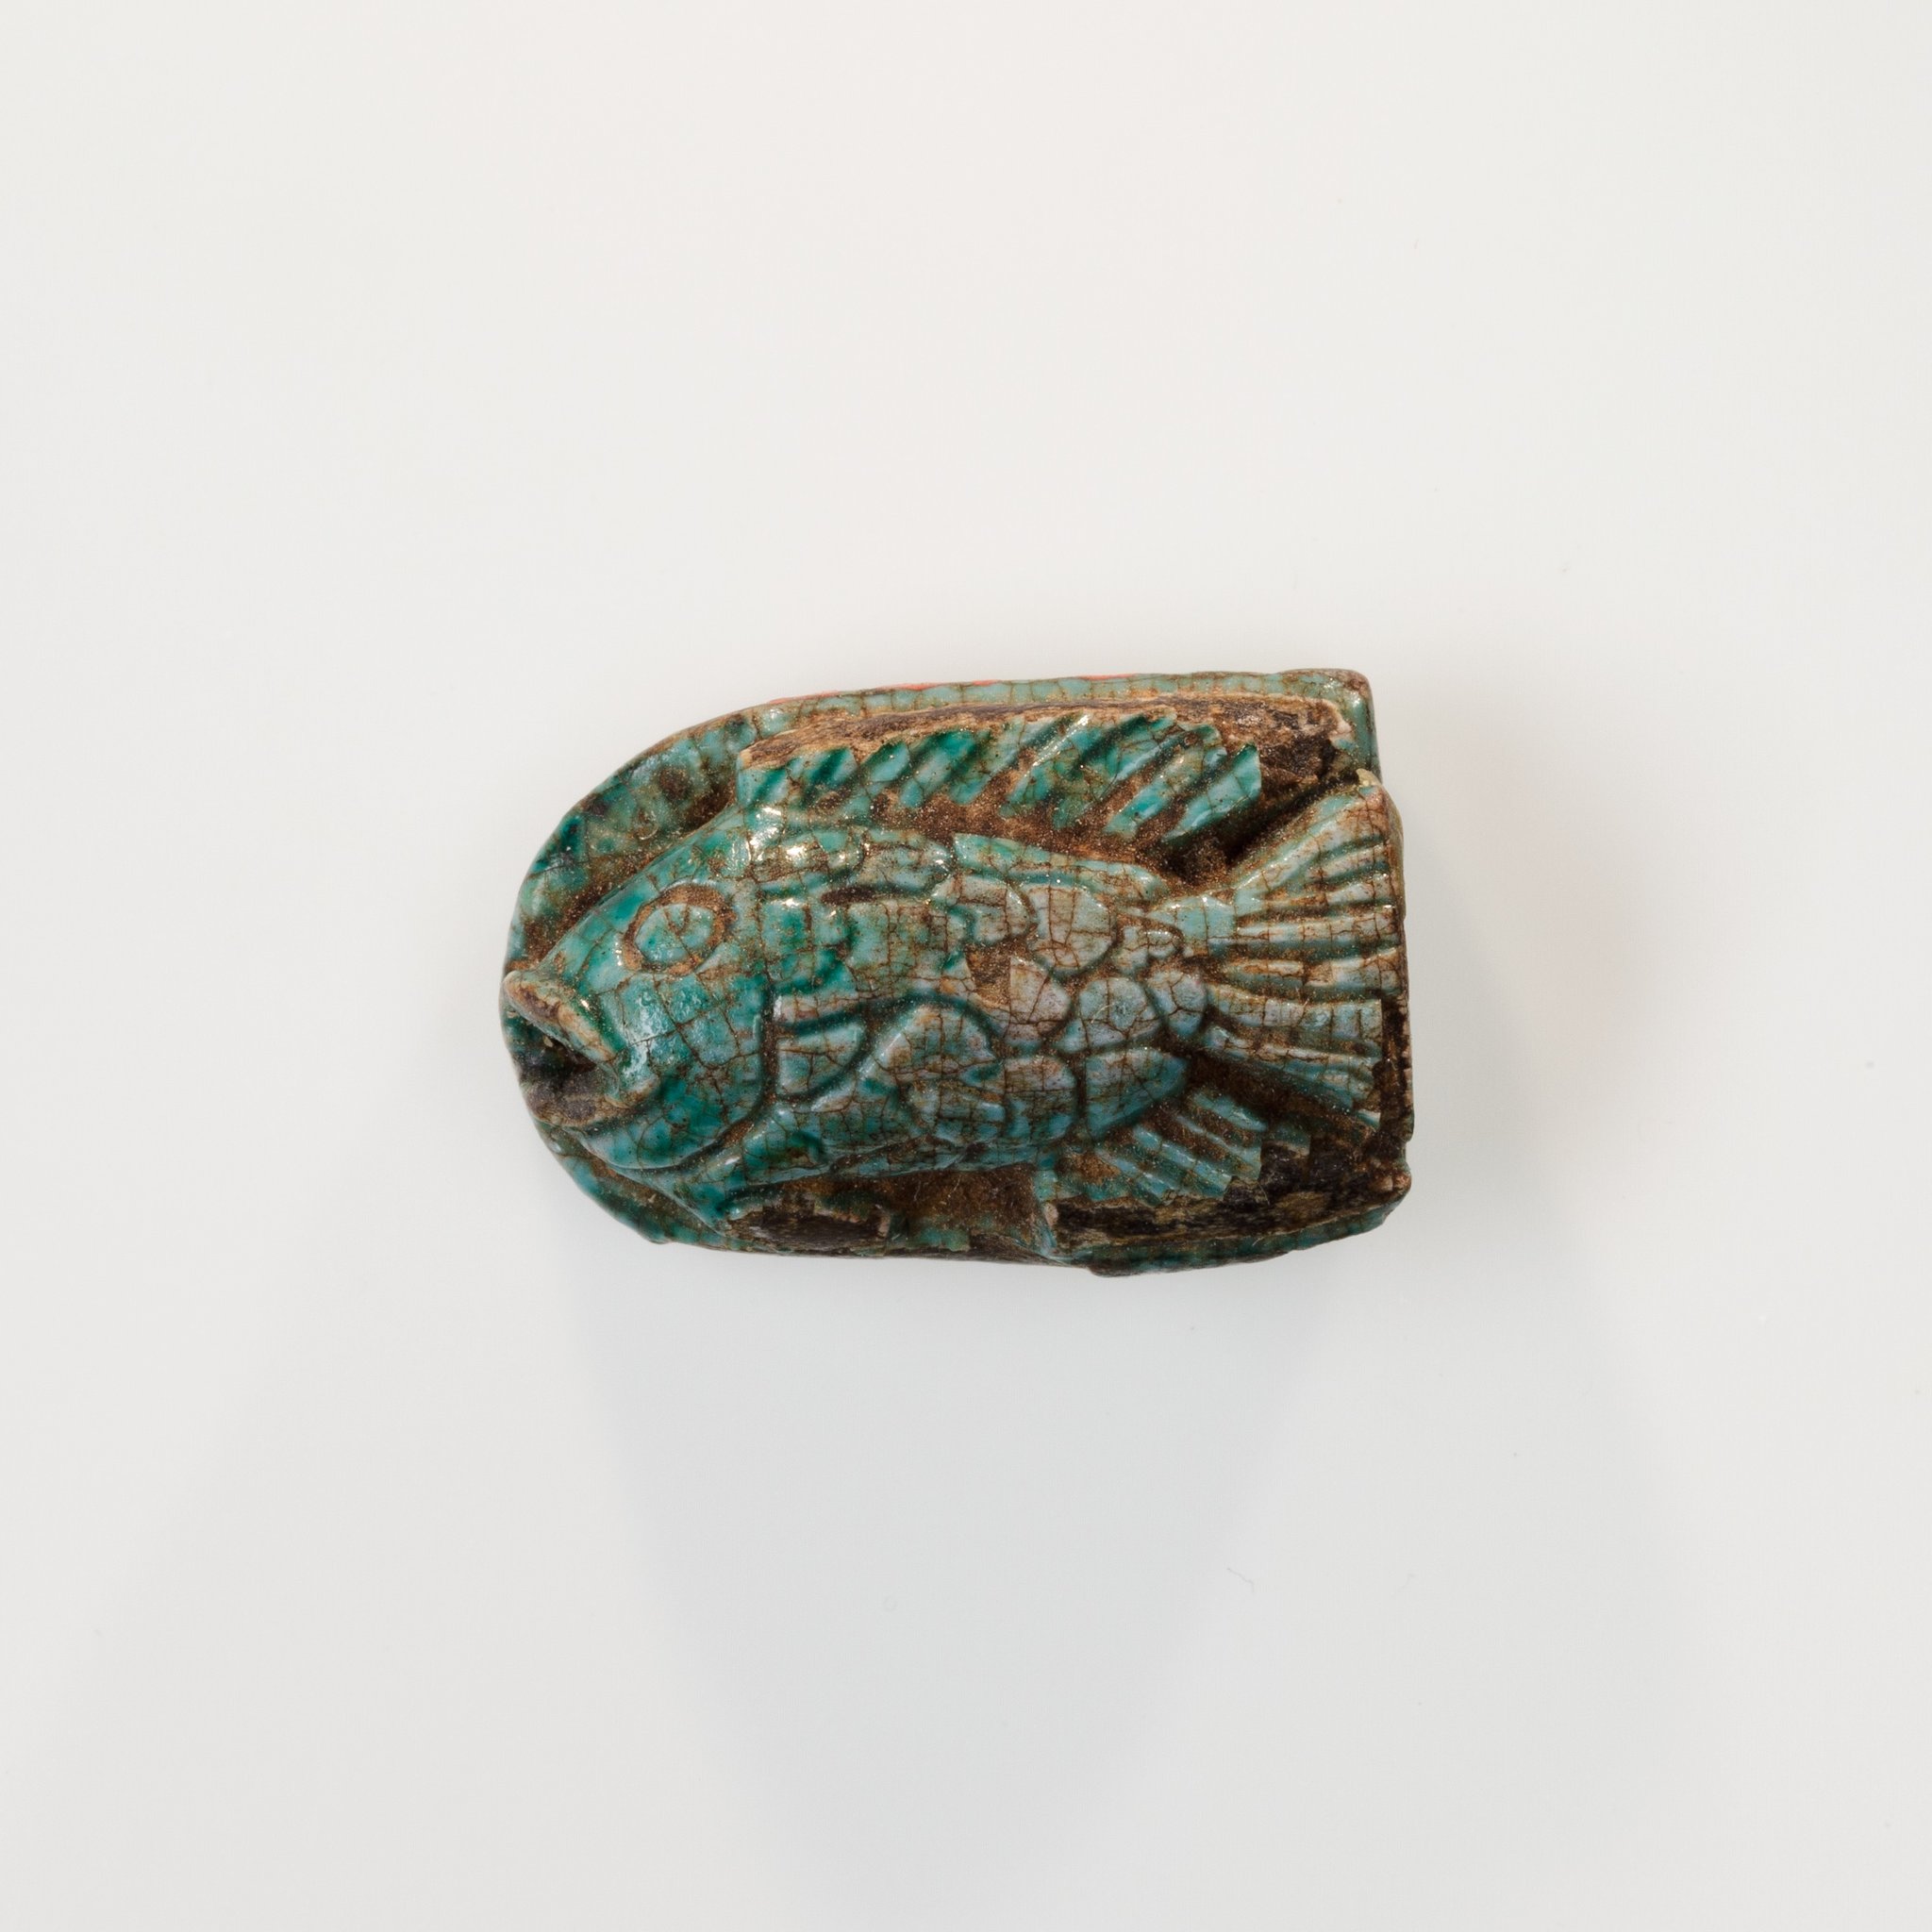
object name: amulet, queen ahmose nefertari, fish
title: Fish Design Amulet Inscribed with the cartouche of Queen Ahmose Nefertari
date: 1550-1479 BCE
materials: stone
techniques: glazing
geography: egypt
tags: hieroglyphs,fish